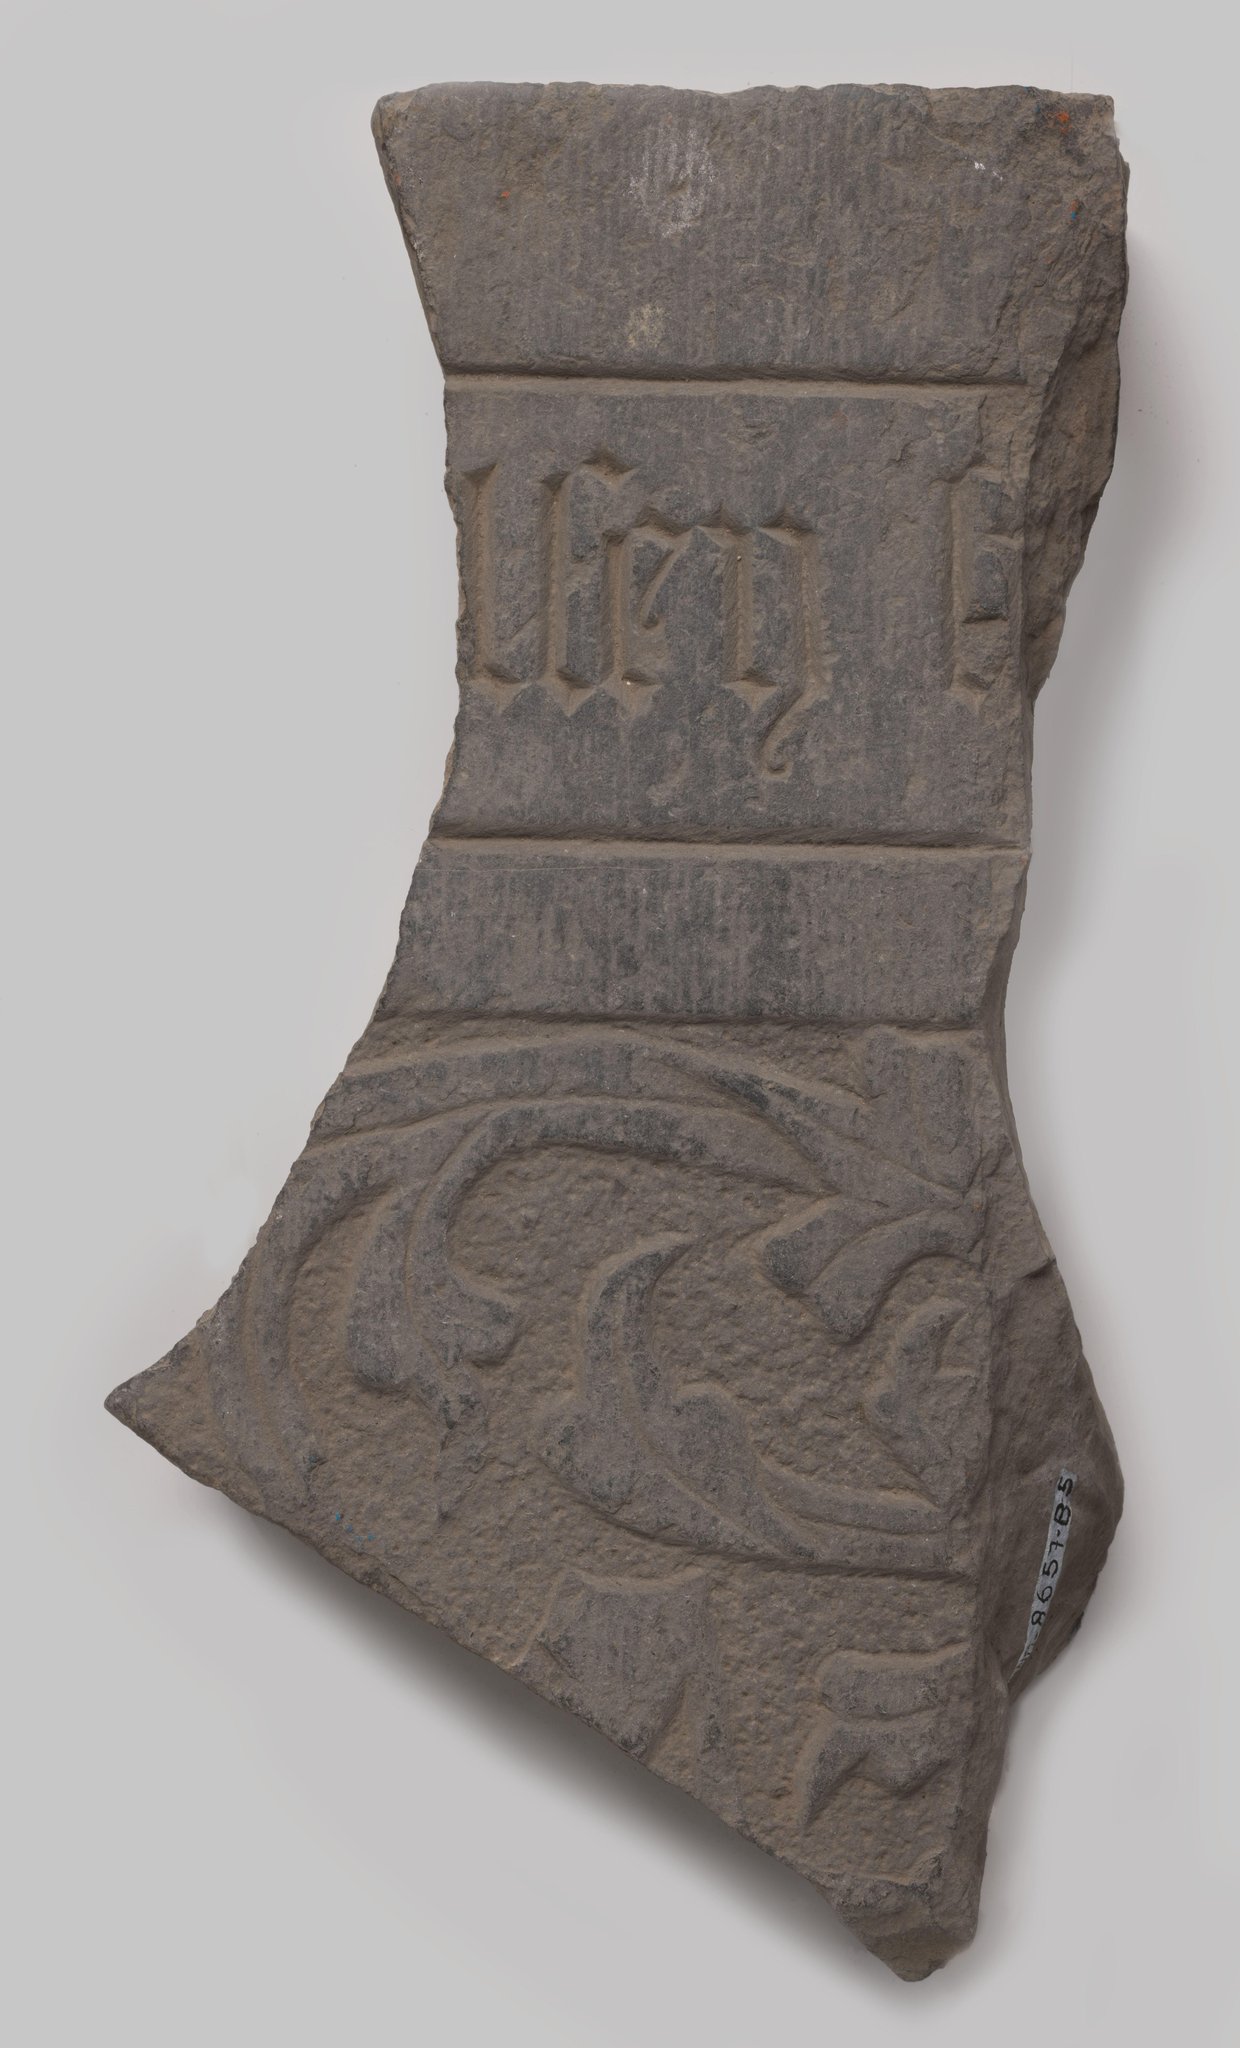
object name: grafzerk, zerk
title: Fragment van een grafzerk met beeldhouwwerk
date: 1497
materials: stone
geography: berne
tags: bern (gelderland)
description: Fragment van de linkerzijkant van de grafzerk van Arent van Malsen. Het fragment heeft een rondschrift en bladranken op het middenveld. Het fragment hoort bij zeven fragmenten van een incomplete grafzerk (BK-NM-8657-B-1 t/m BK-NM-8657-B-8).